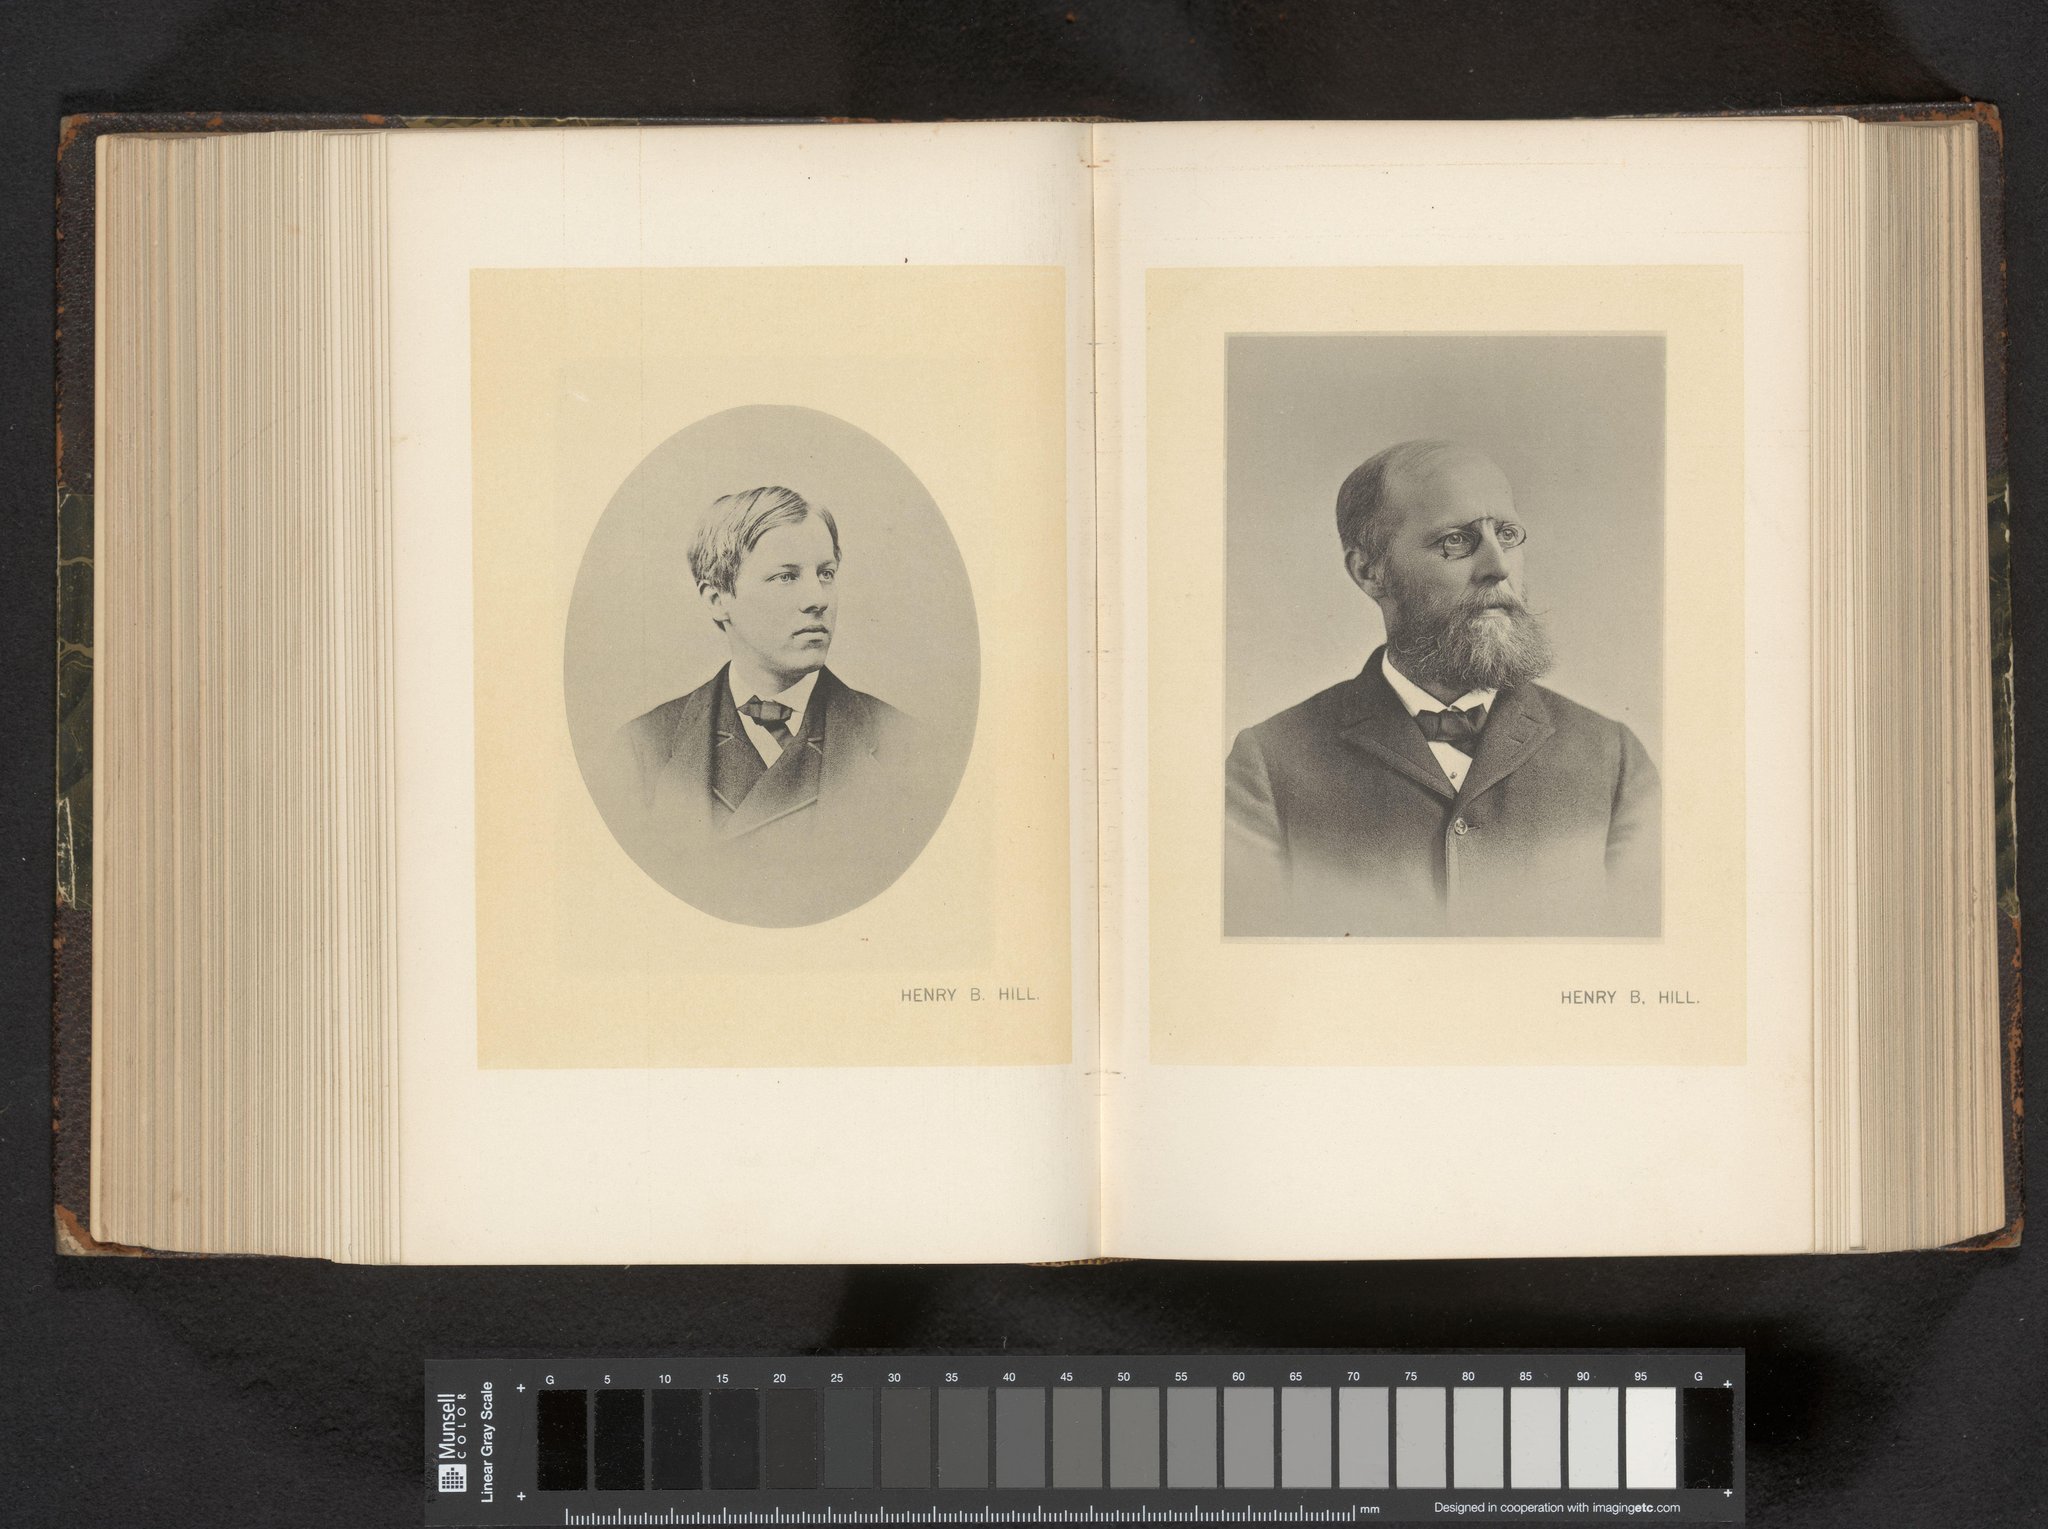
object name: page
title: Henry B. Hill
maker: Anonymous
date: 1869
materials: paper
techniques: photoaquatint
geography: boston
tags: adult man